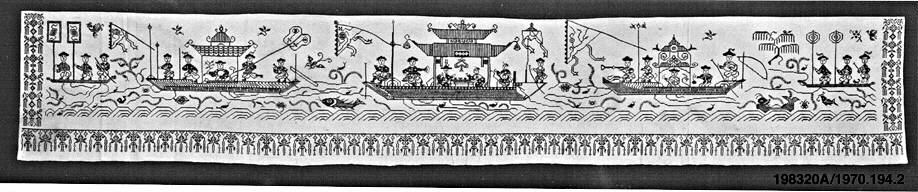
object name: valance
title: Valance for Bed with Naval Scenes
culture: chinese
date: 1801-1900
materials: cotton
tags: fish,ships